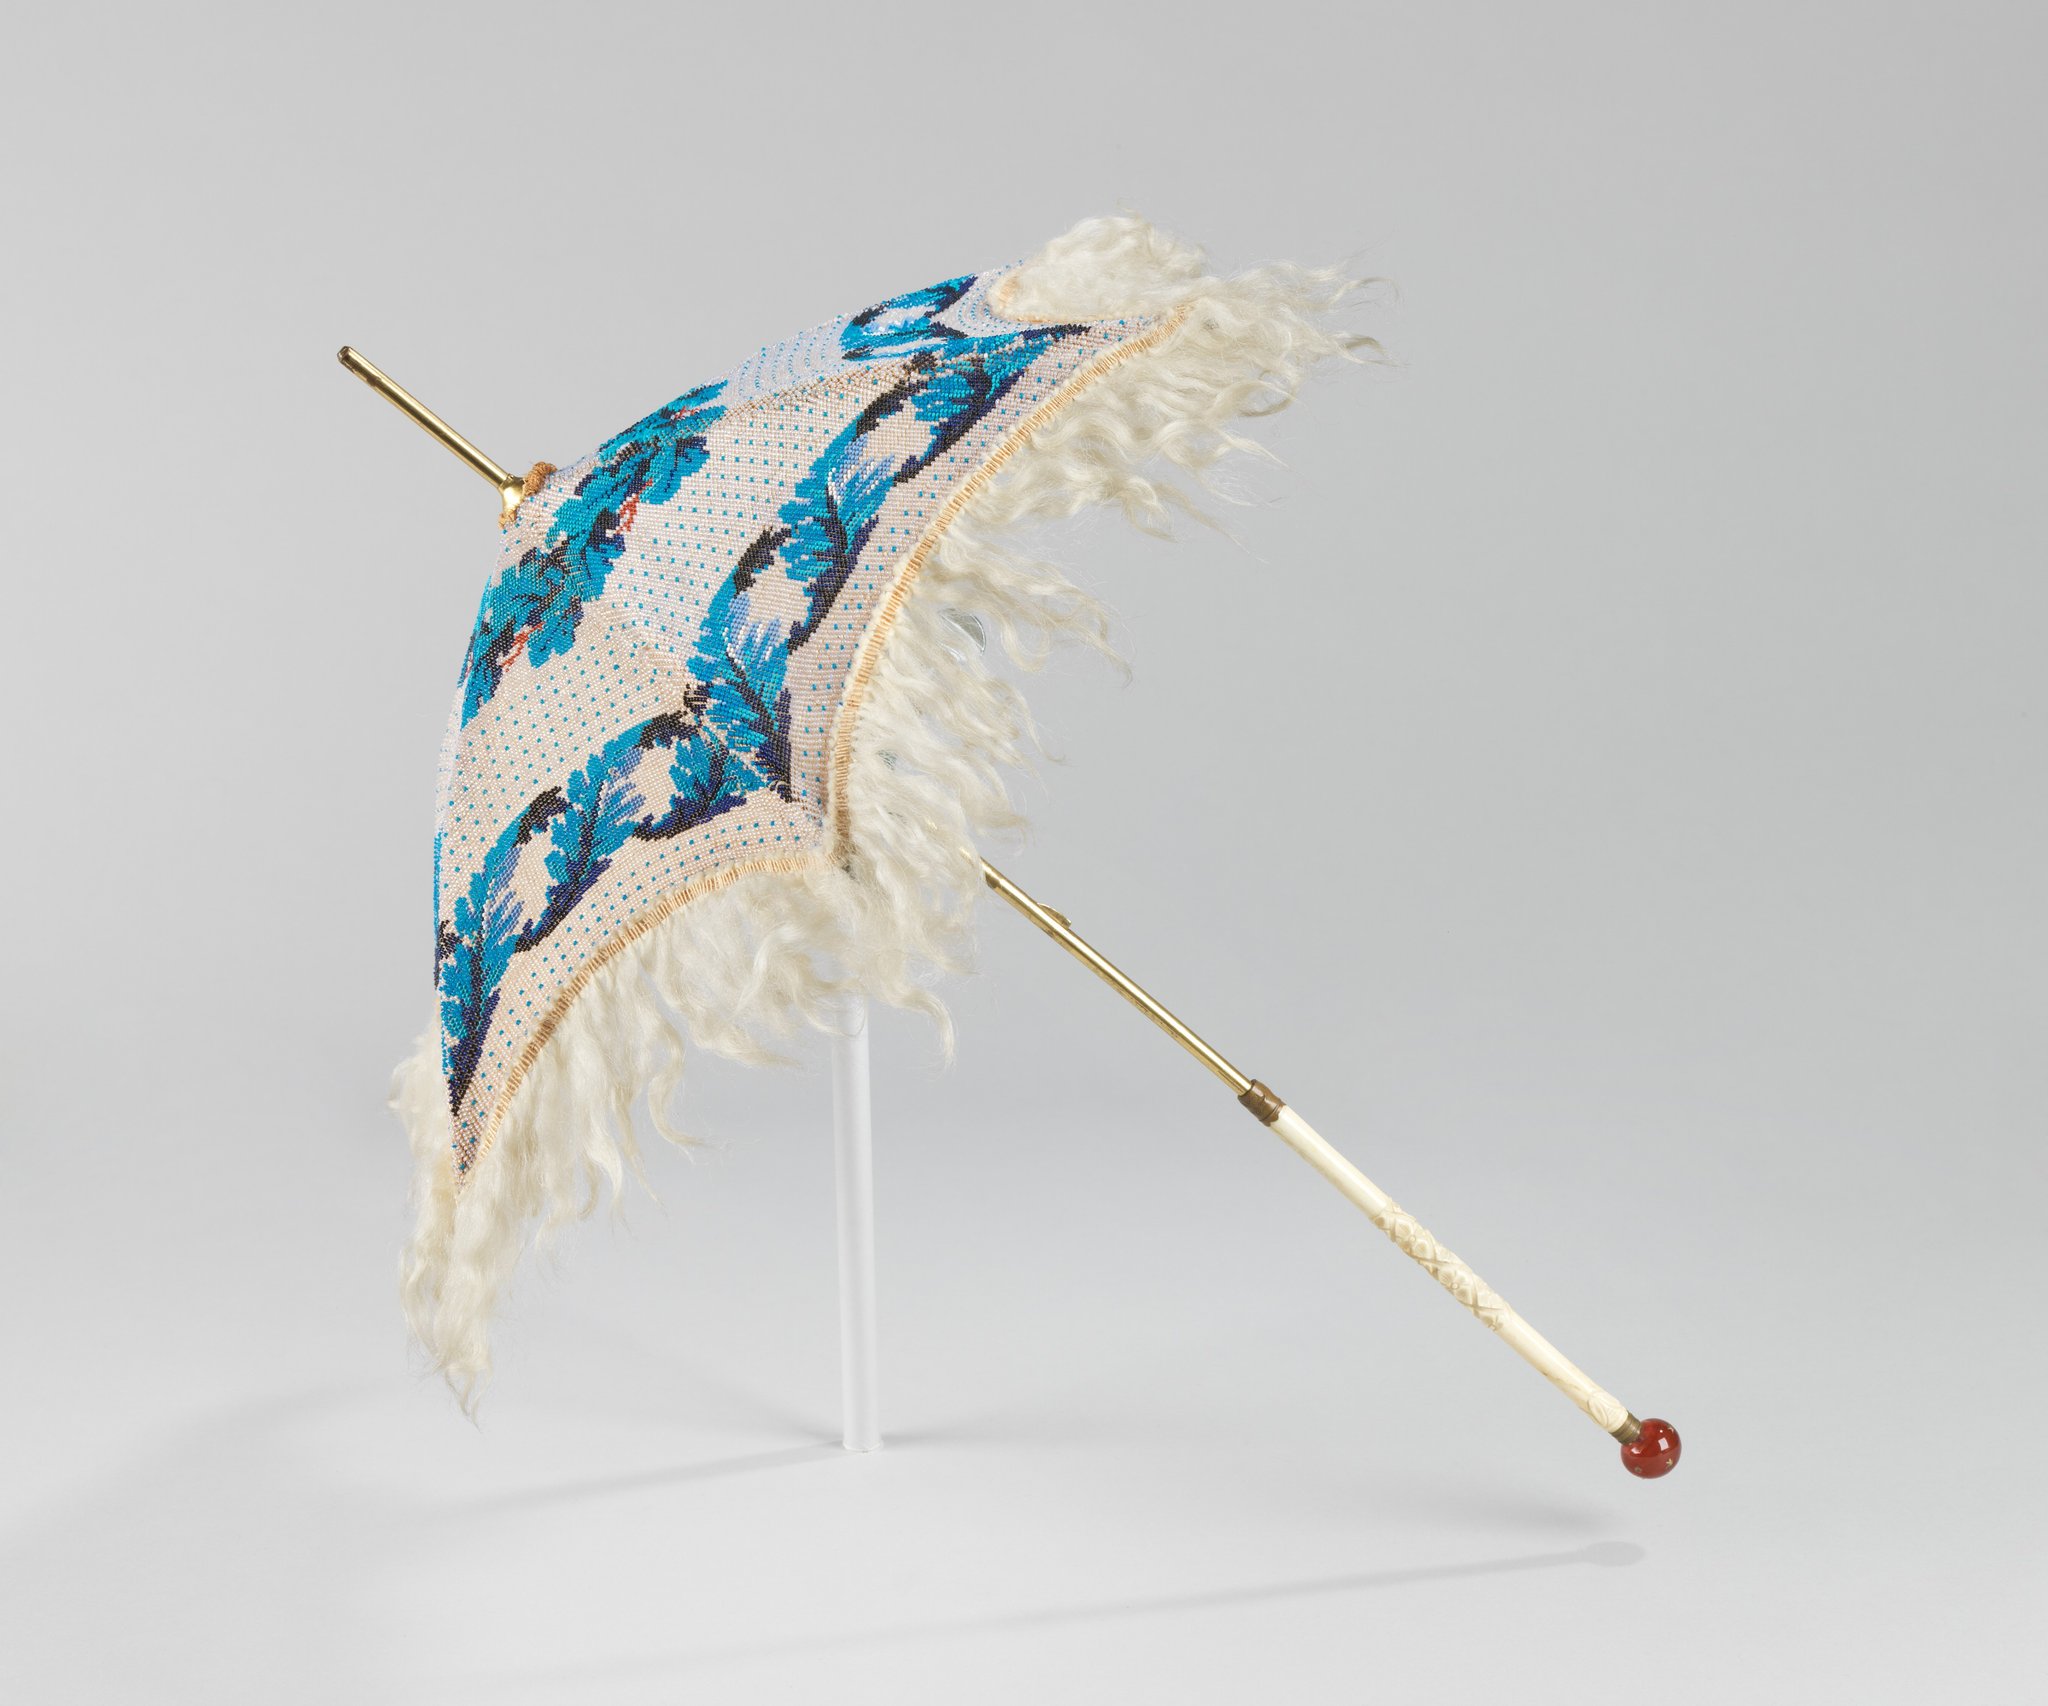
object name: parasol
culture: french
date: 1850-1870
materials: glass, hair, ivory, linen, metal, silk